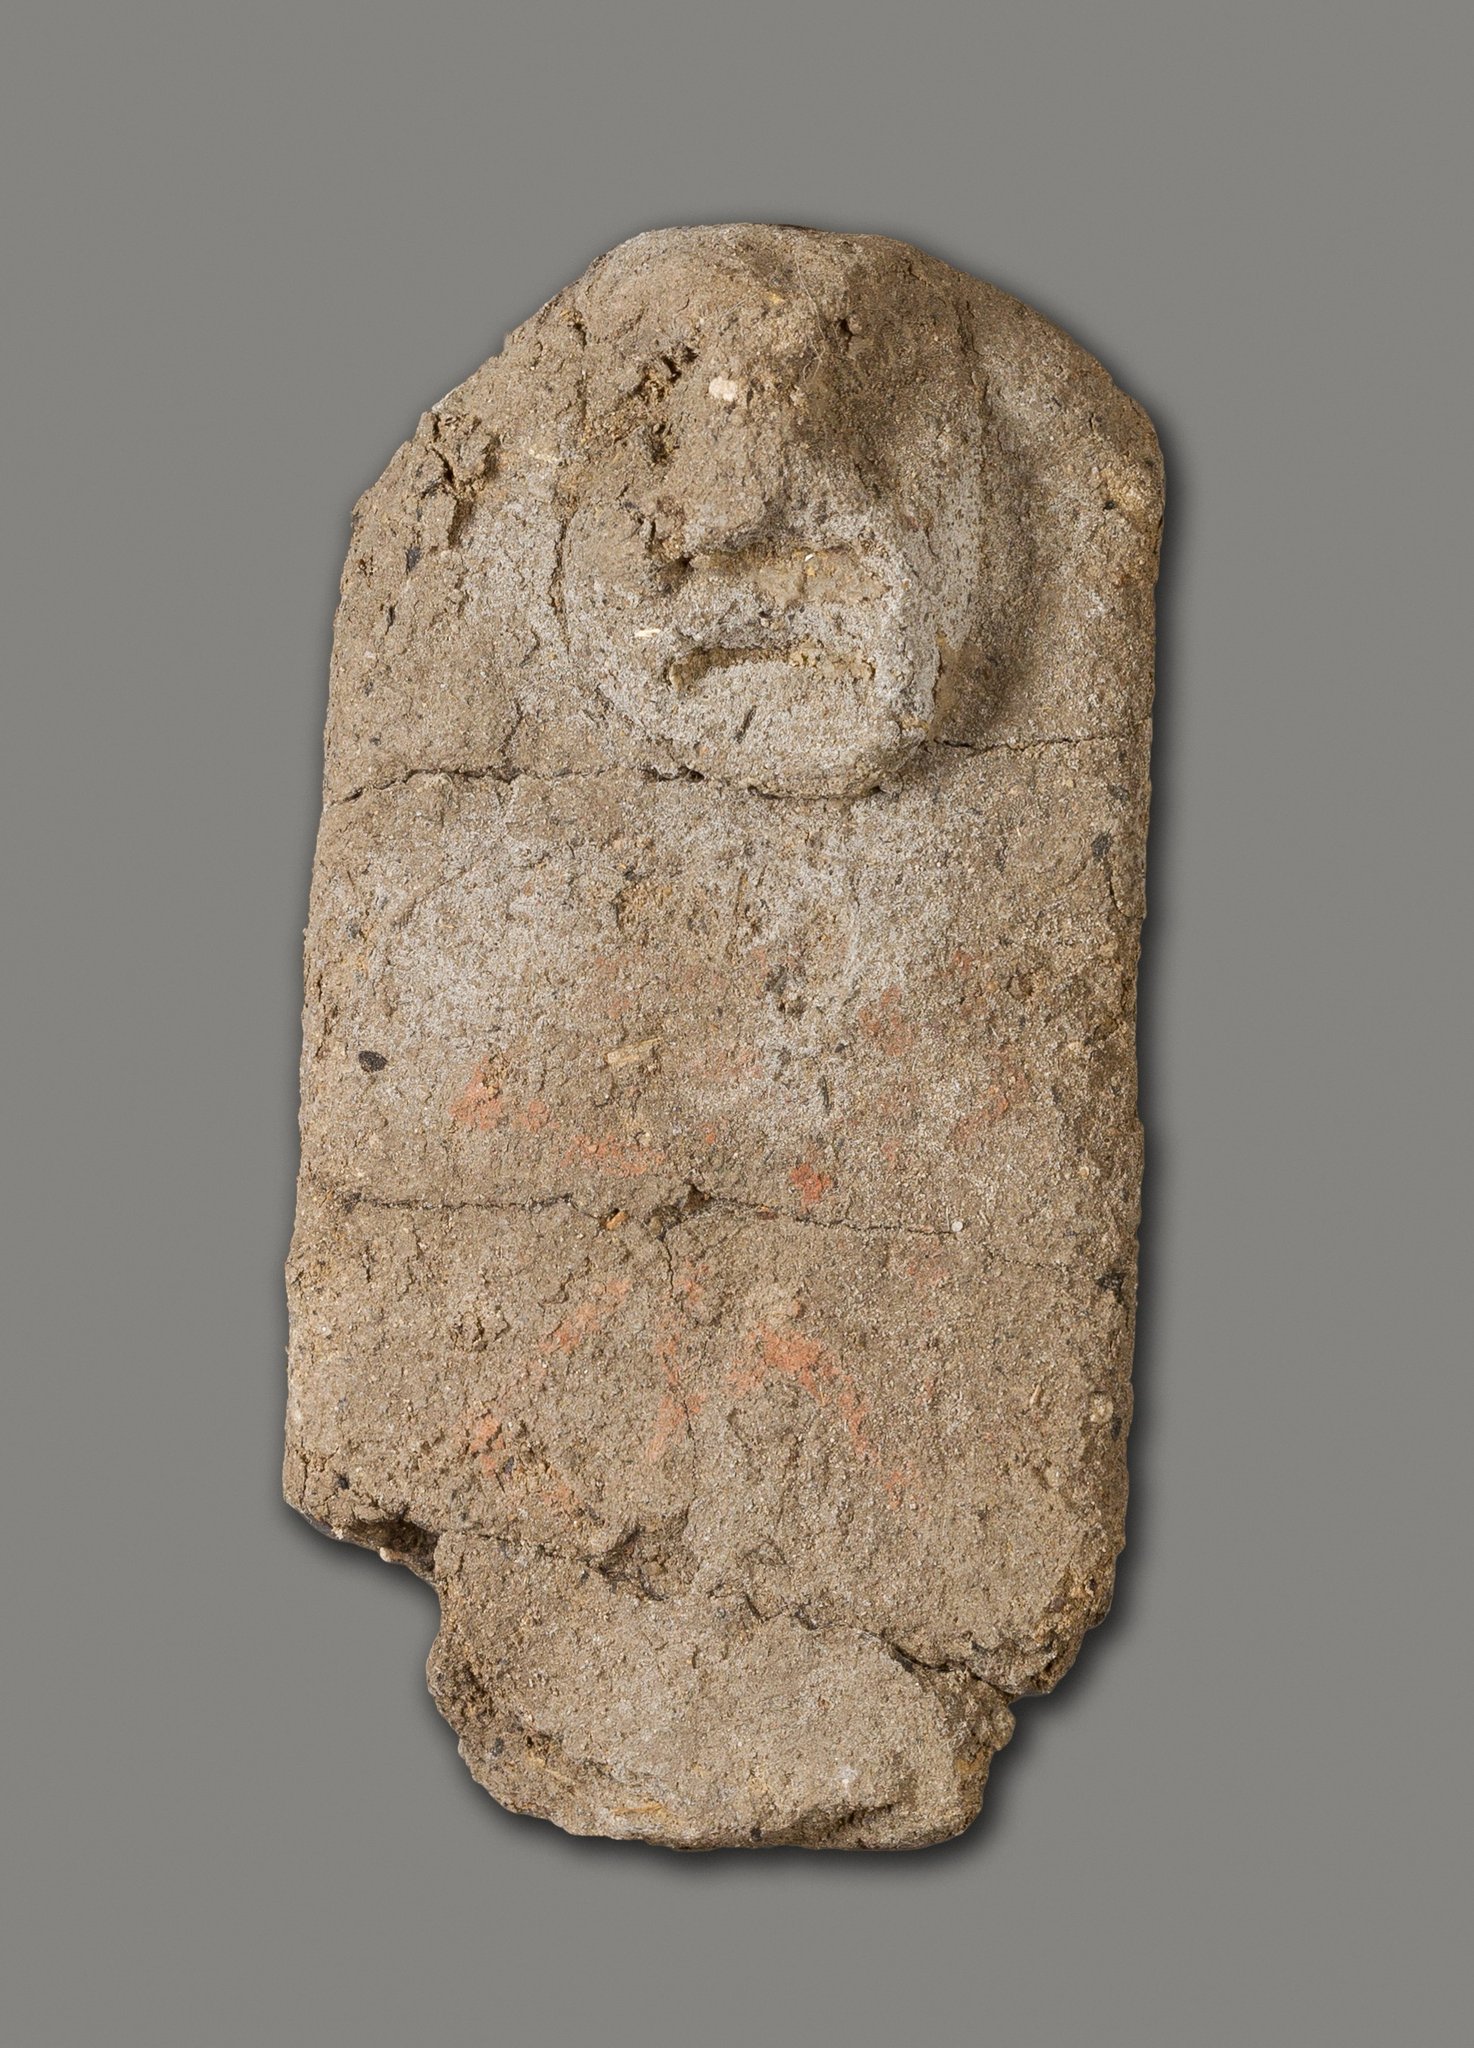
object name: figure, magical, execration, tablet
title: Magical Figure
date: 1802-1550 BCE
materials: clay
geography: egypt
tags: faces